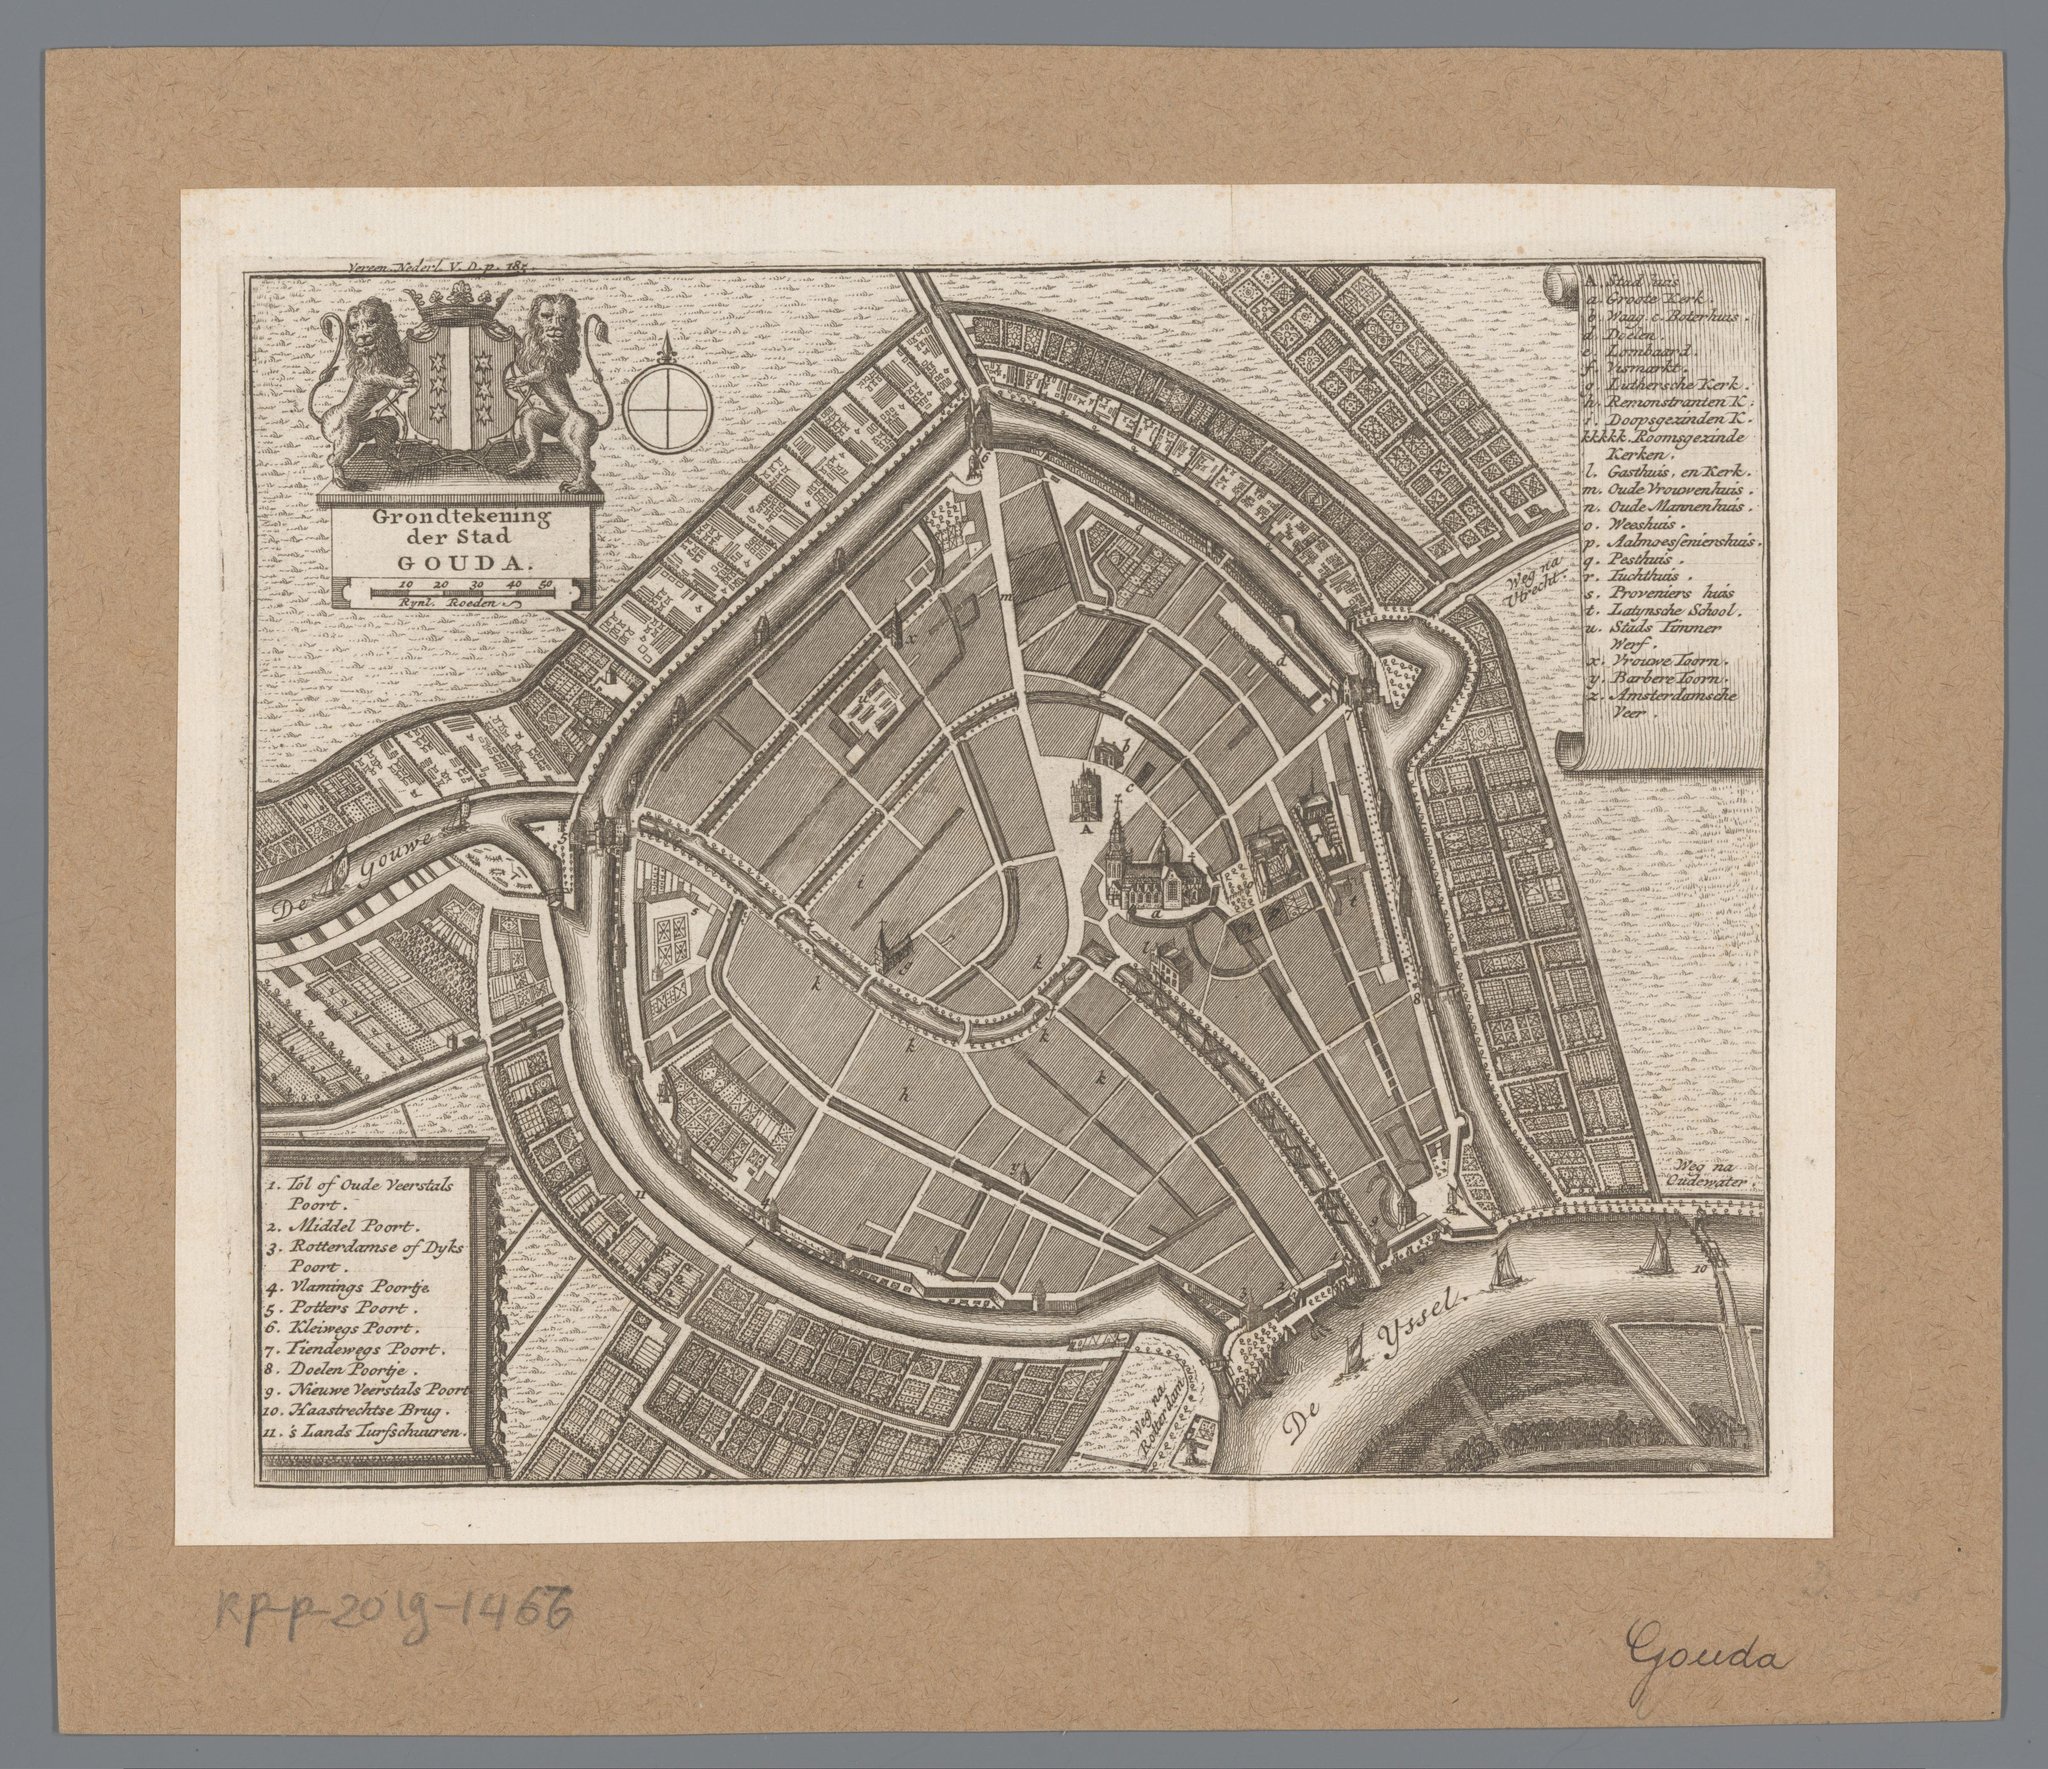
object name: book illustration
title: Grondtekening der Stad Gouda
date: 1744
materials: paper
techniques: etching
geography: amsterdam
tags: maps of cities, gouda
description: Prent uit: Wagenaar, Jan. Tegenwoordige Staat der Vereenigde Nederlanden (...). Amsterdam: Isaak Tirion, 1744, dl. 5, p. 185.